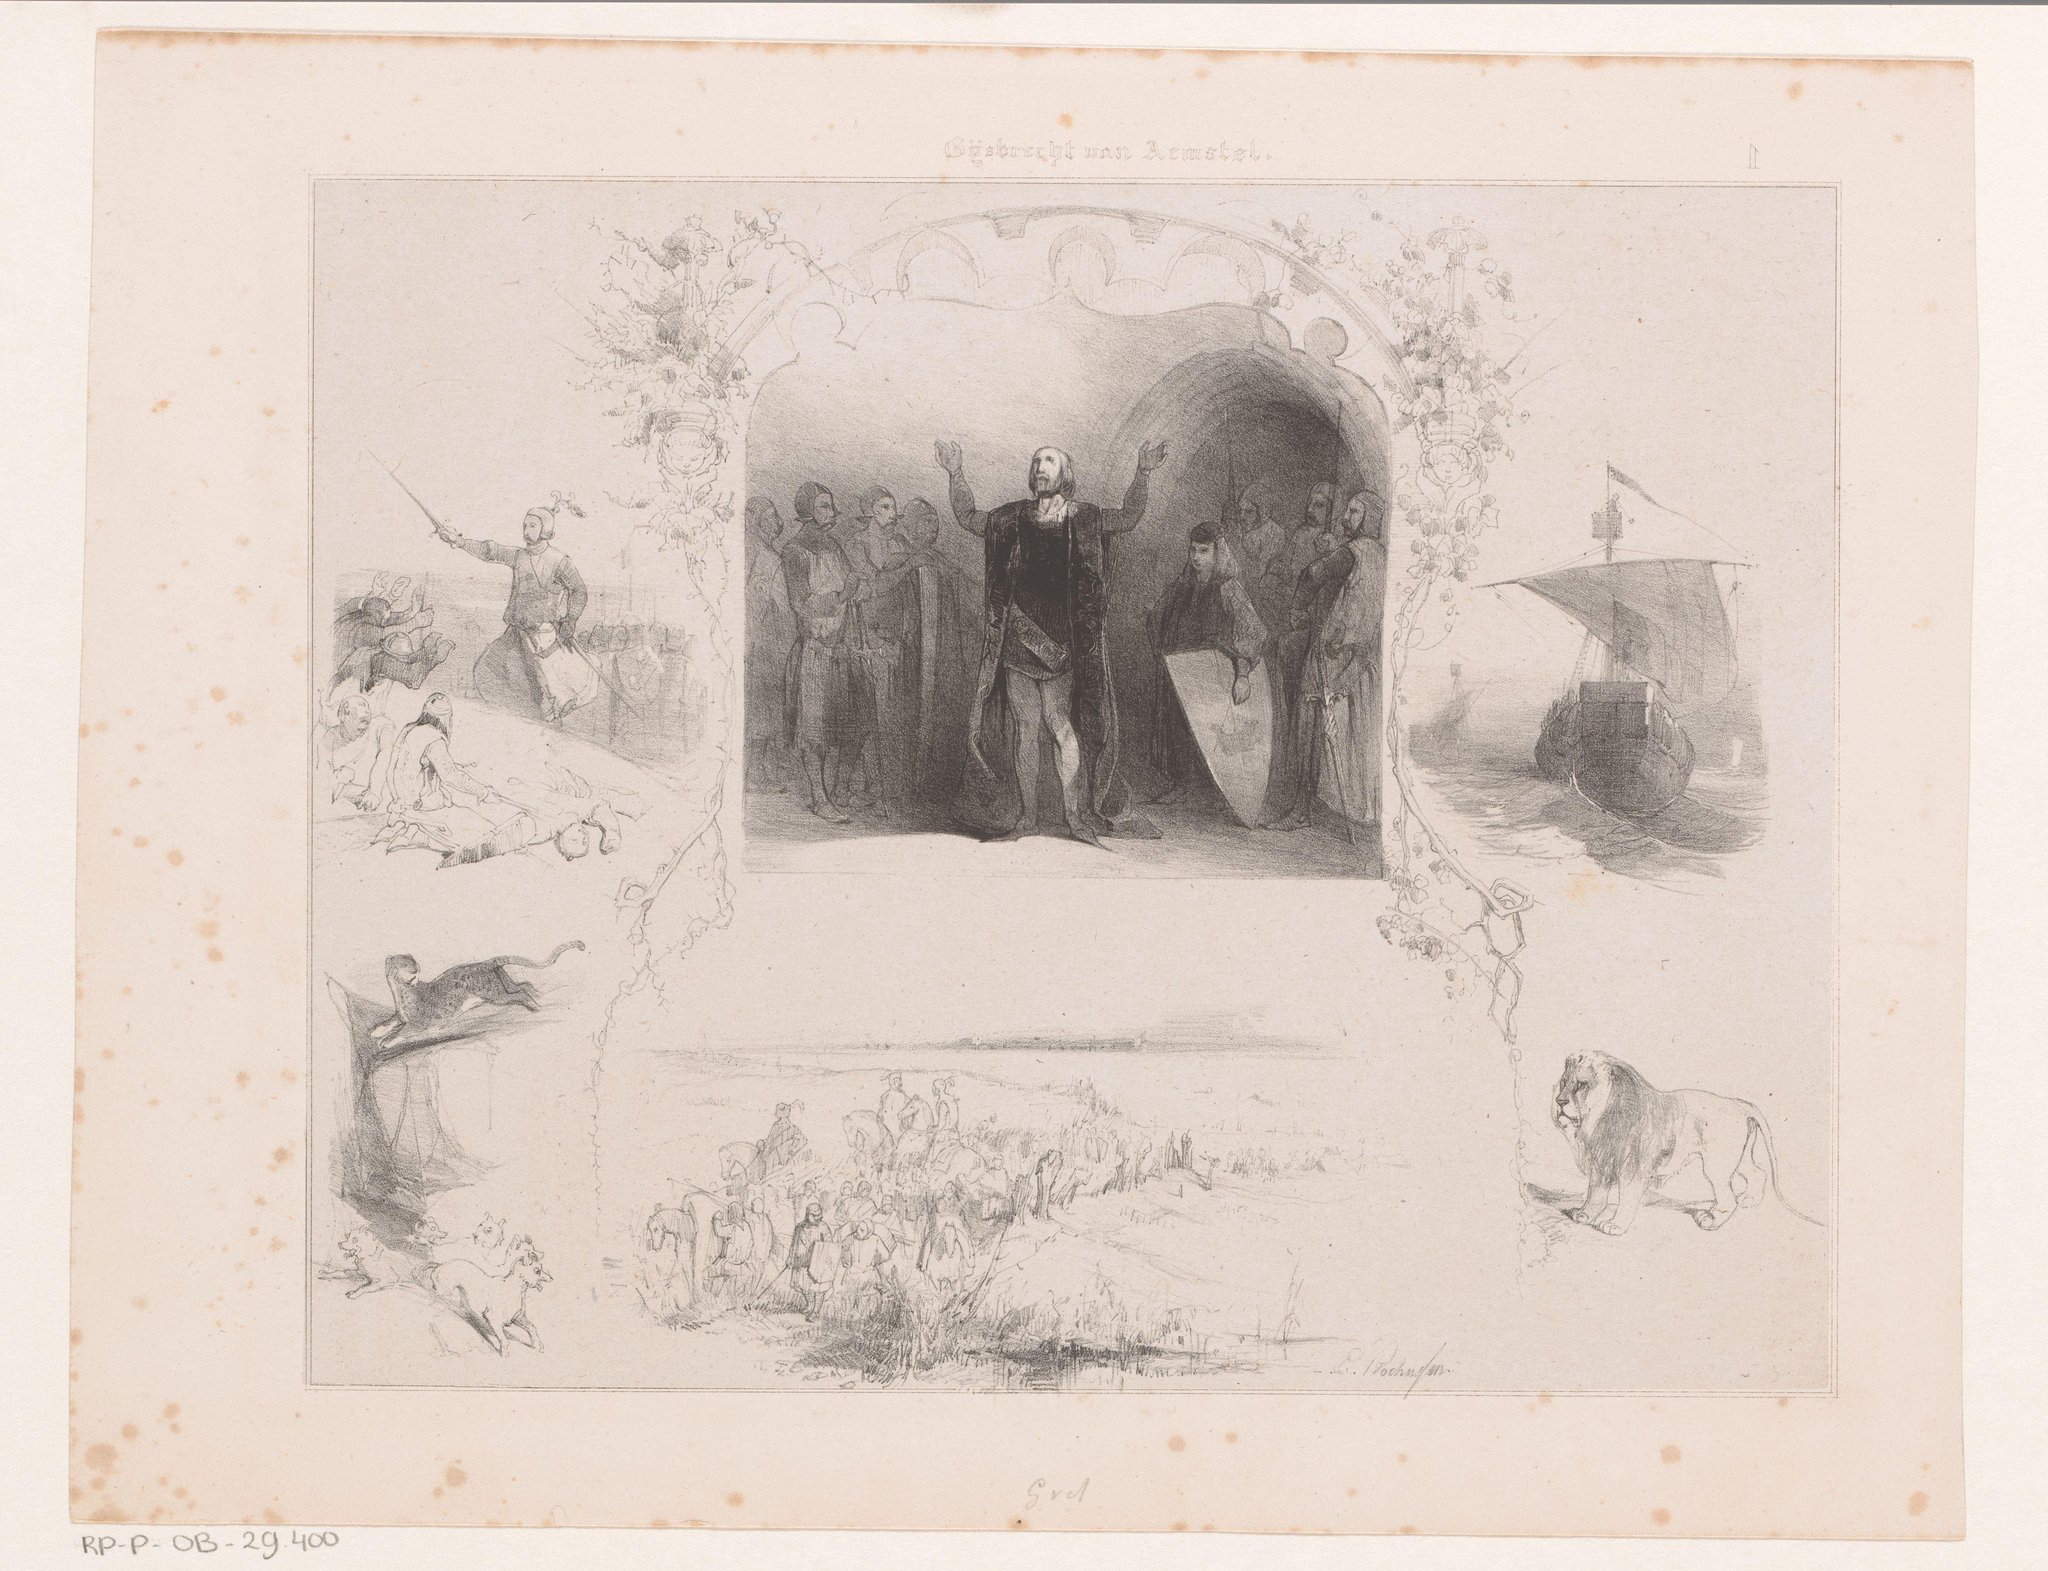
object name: print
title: Man met opgeheven armen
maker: charles rochussen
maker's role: draughtsman, painter, print maker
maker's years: 1814-1894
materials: paper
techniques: lithograph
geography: the hague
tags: standing figure, knight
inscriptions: collector's mark: Lugt 2228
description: Prent uit: Vondel, Joost van den. Gysbrecht van Aemstel, treurspel. Den Haag: Nederlandsche Maatschappij van Schoone Kunsten, 1841.